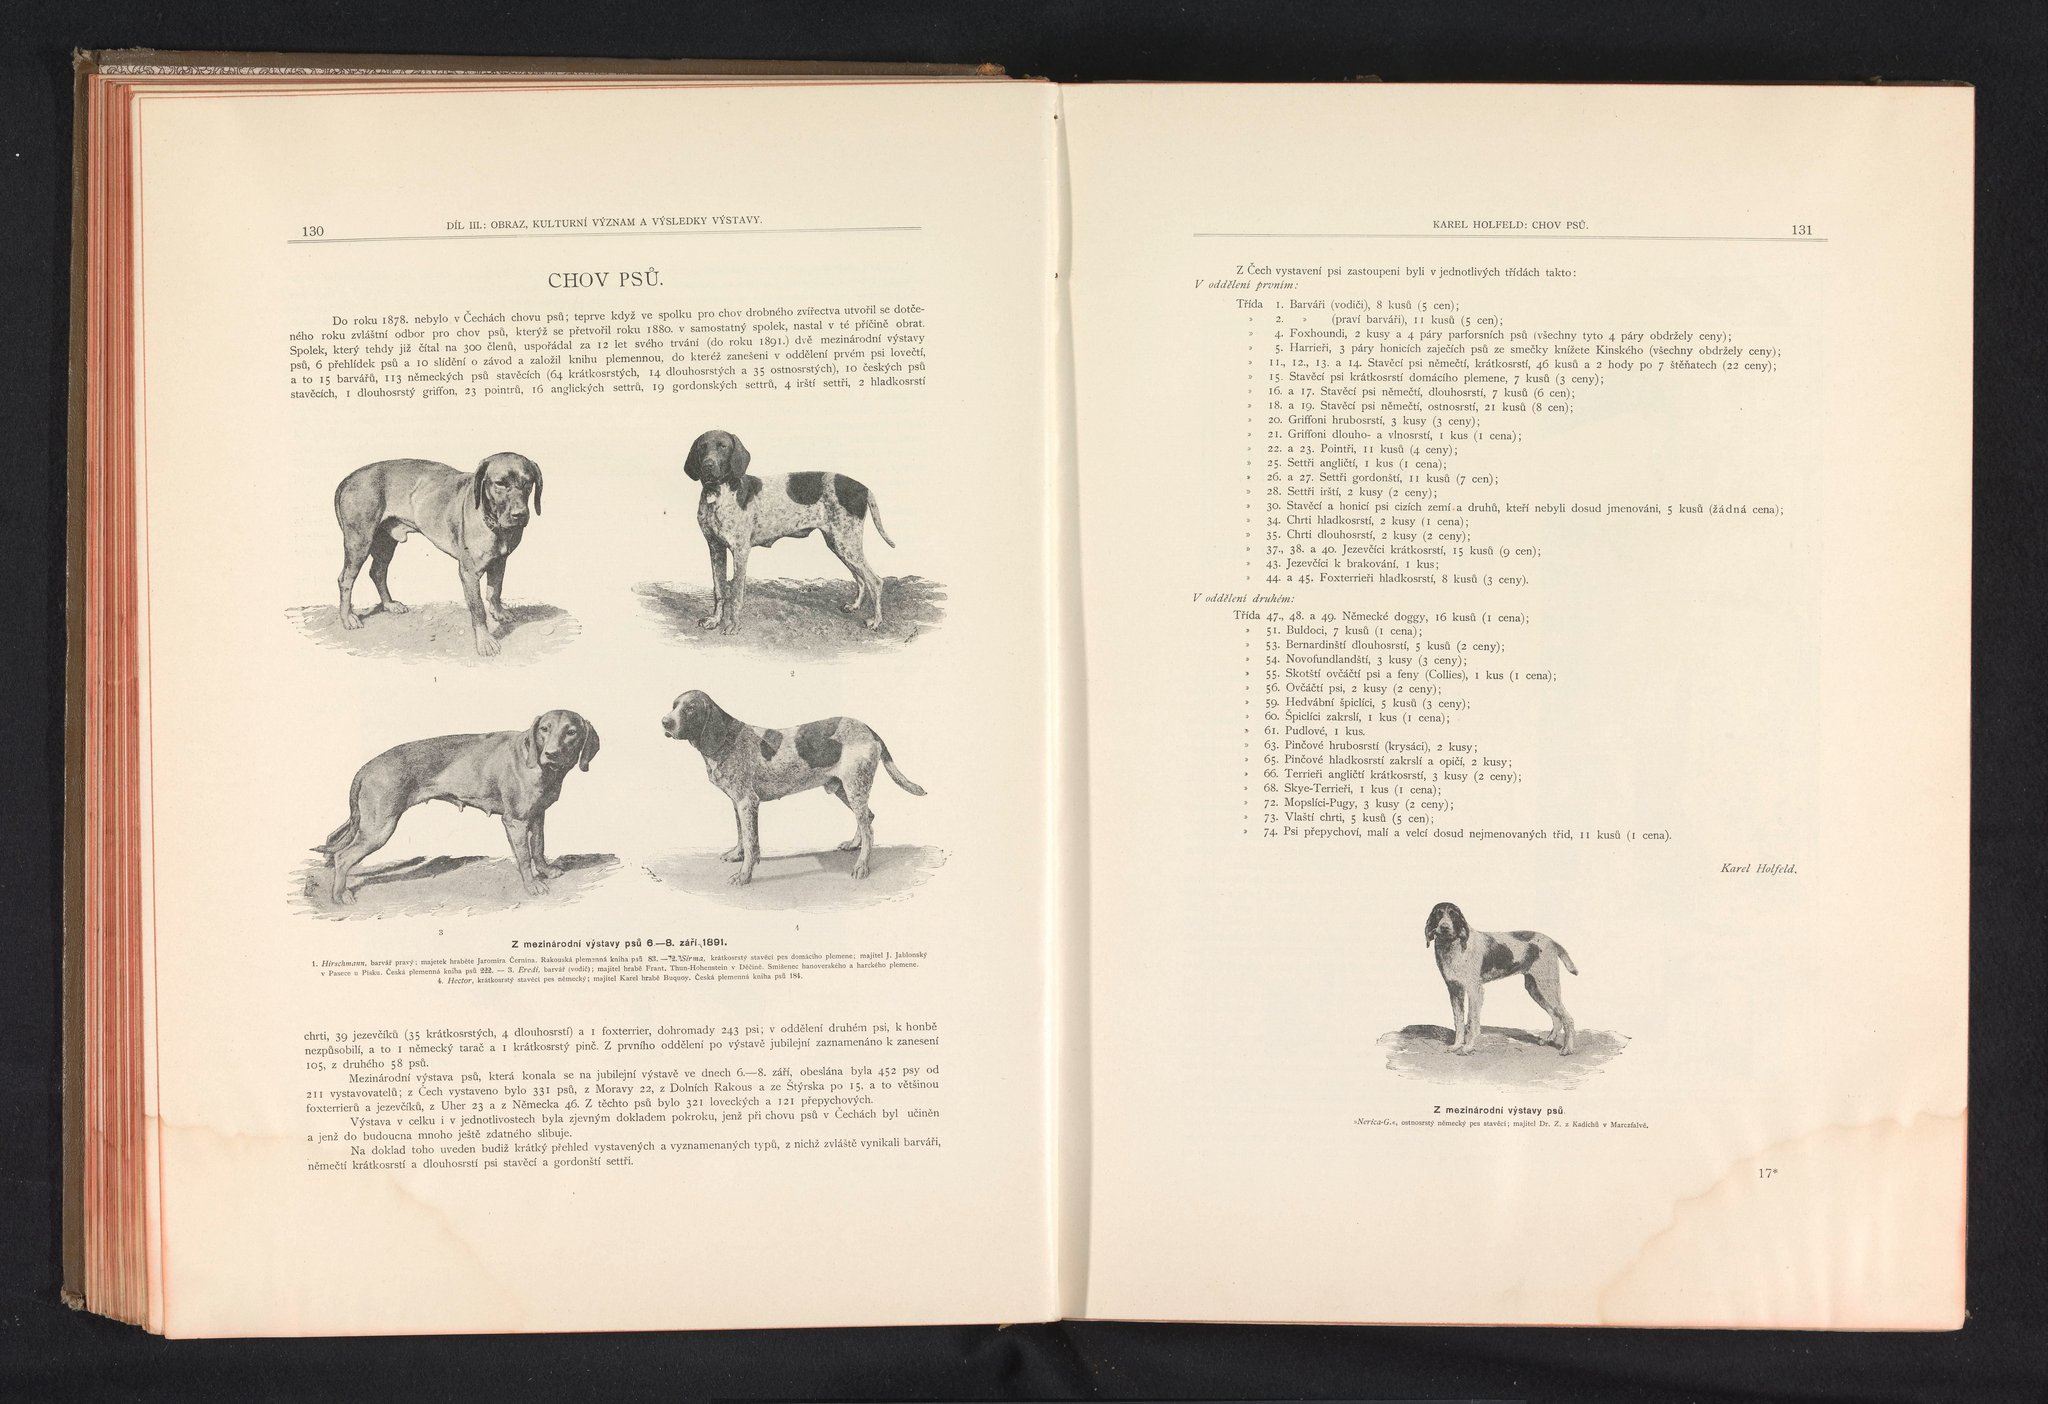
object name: photomechanical print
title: Hond uit de Internationale Hondententoonstelling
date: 1891-1895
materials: paper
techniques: autotype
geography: prague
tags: dog